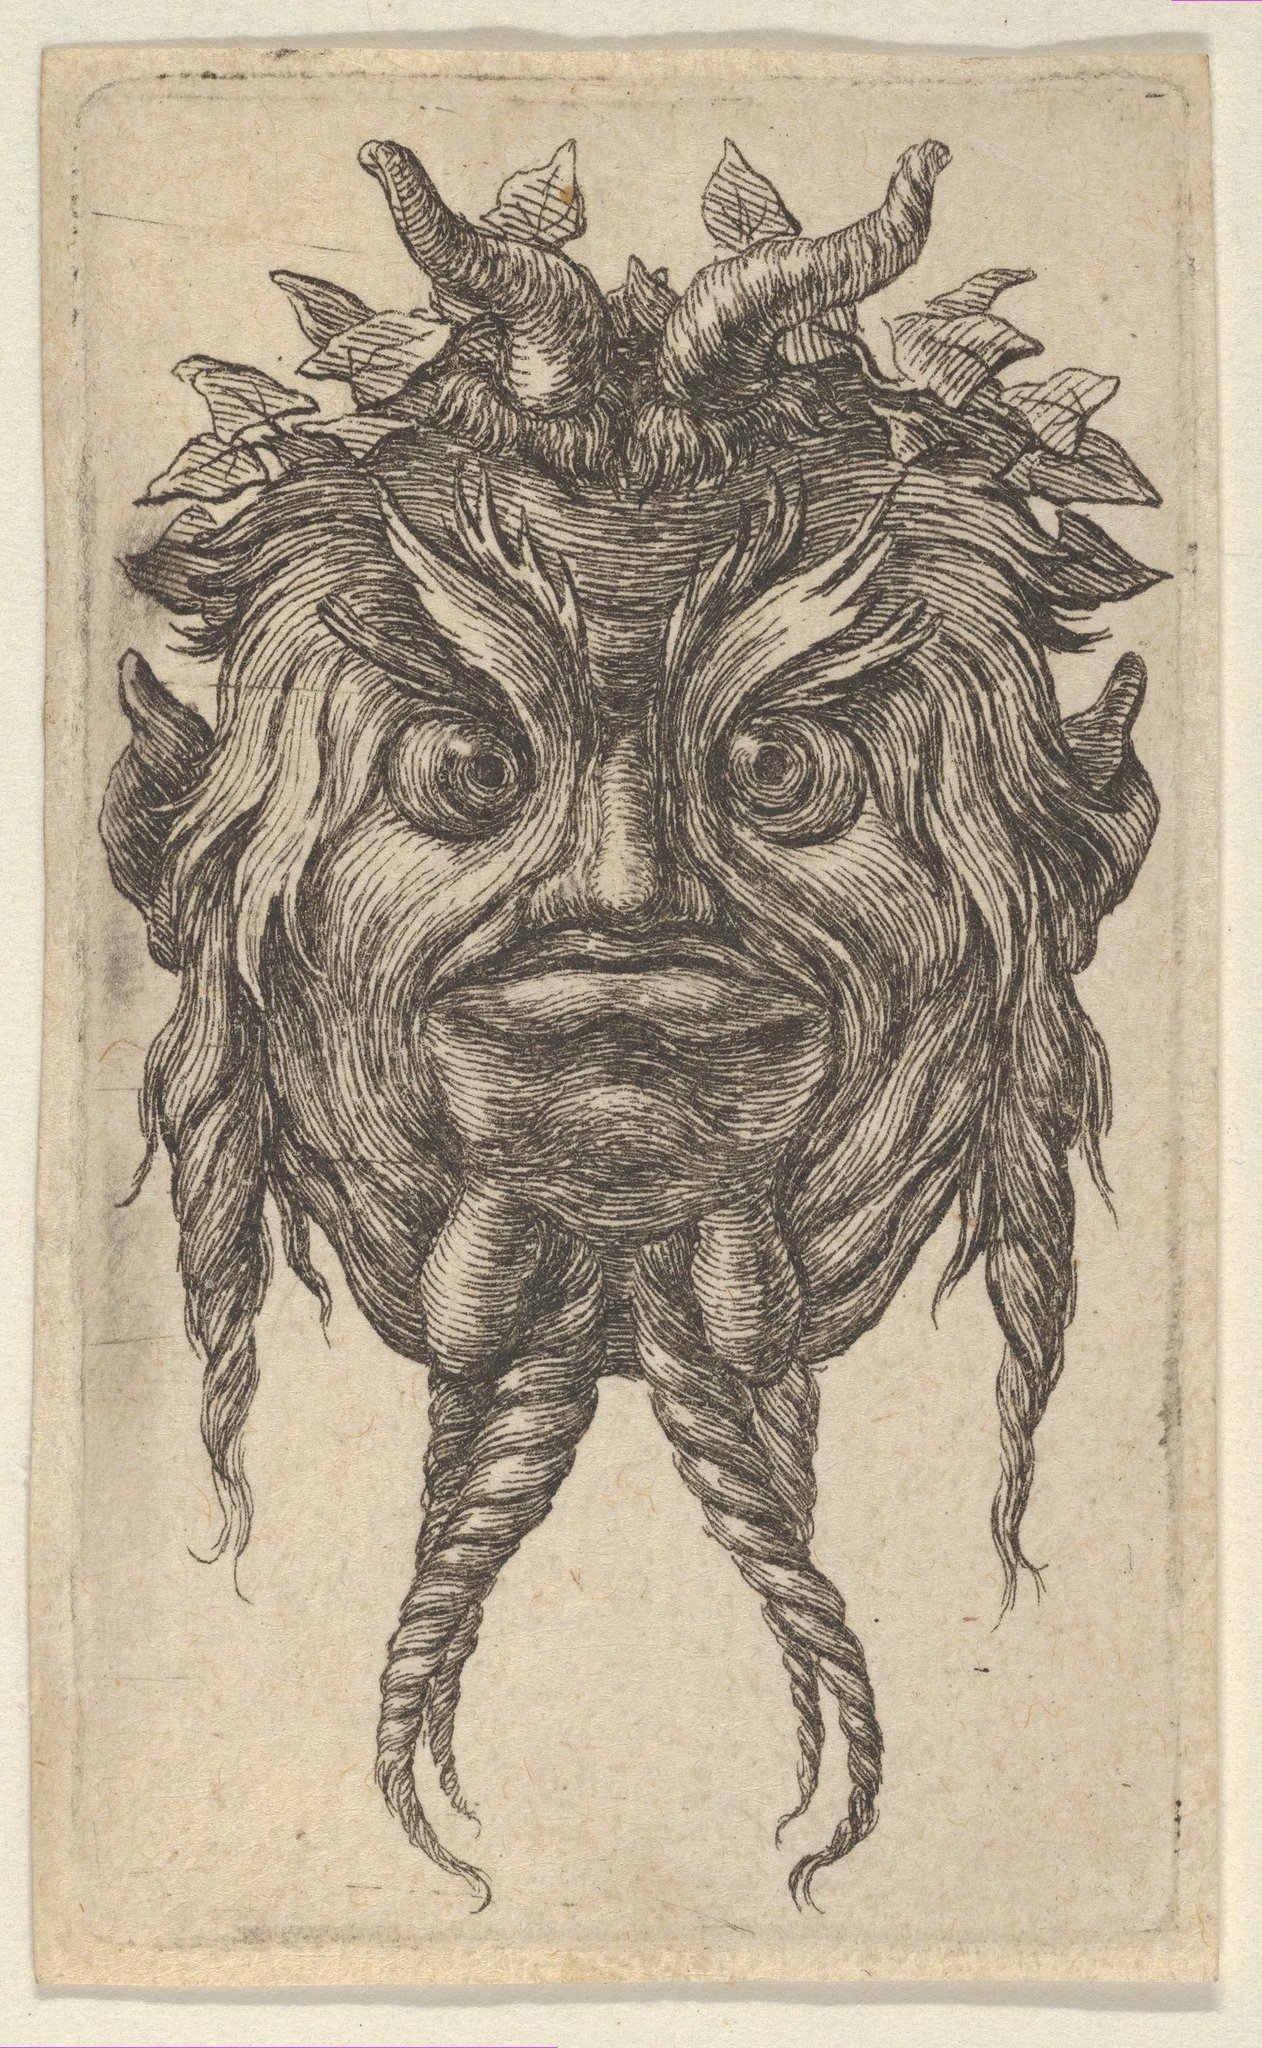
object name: print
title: Satyr Mask with Horns and a Twisted Beard Wearing an Ivy Wreath, from "Divers Masques"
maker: françois chauveau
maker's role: artist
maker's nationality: french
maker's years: 1613-1676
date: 1635-1645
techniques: etching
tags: masks,satyrs